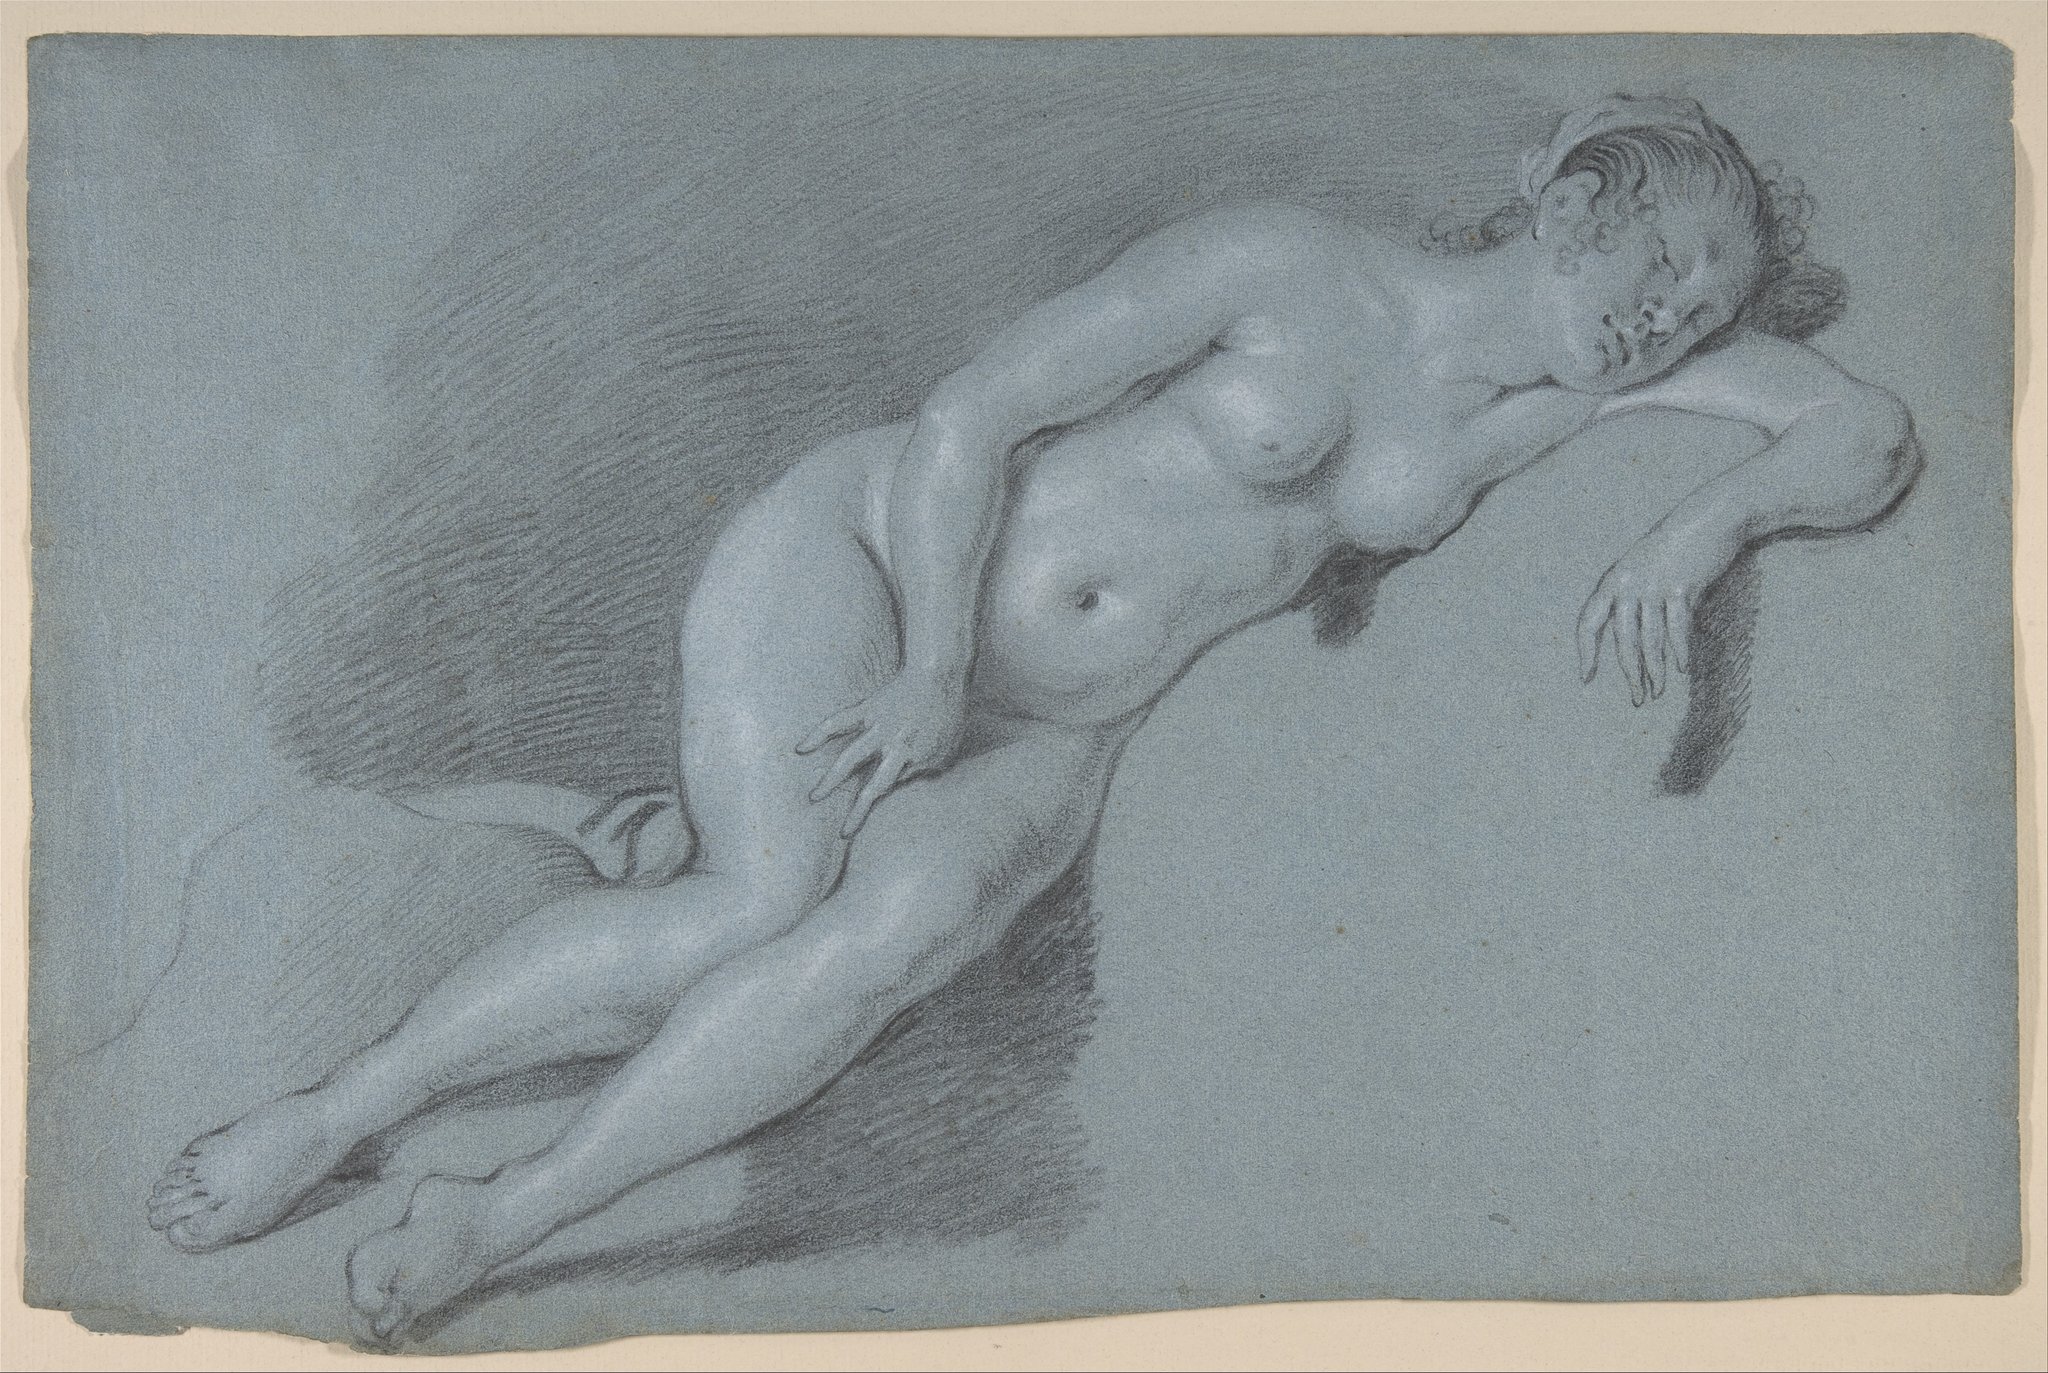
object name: drawing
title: Reclining Female Nude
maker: govert flinck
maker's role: artist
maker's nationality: dutch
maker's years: 1615-1660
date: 1634-1666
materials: chalk, paper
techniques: heightening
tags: female nudes